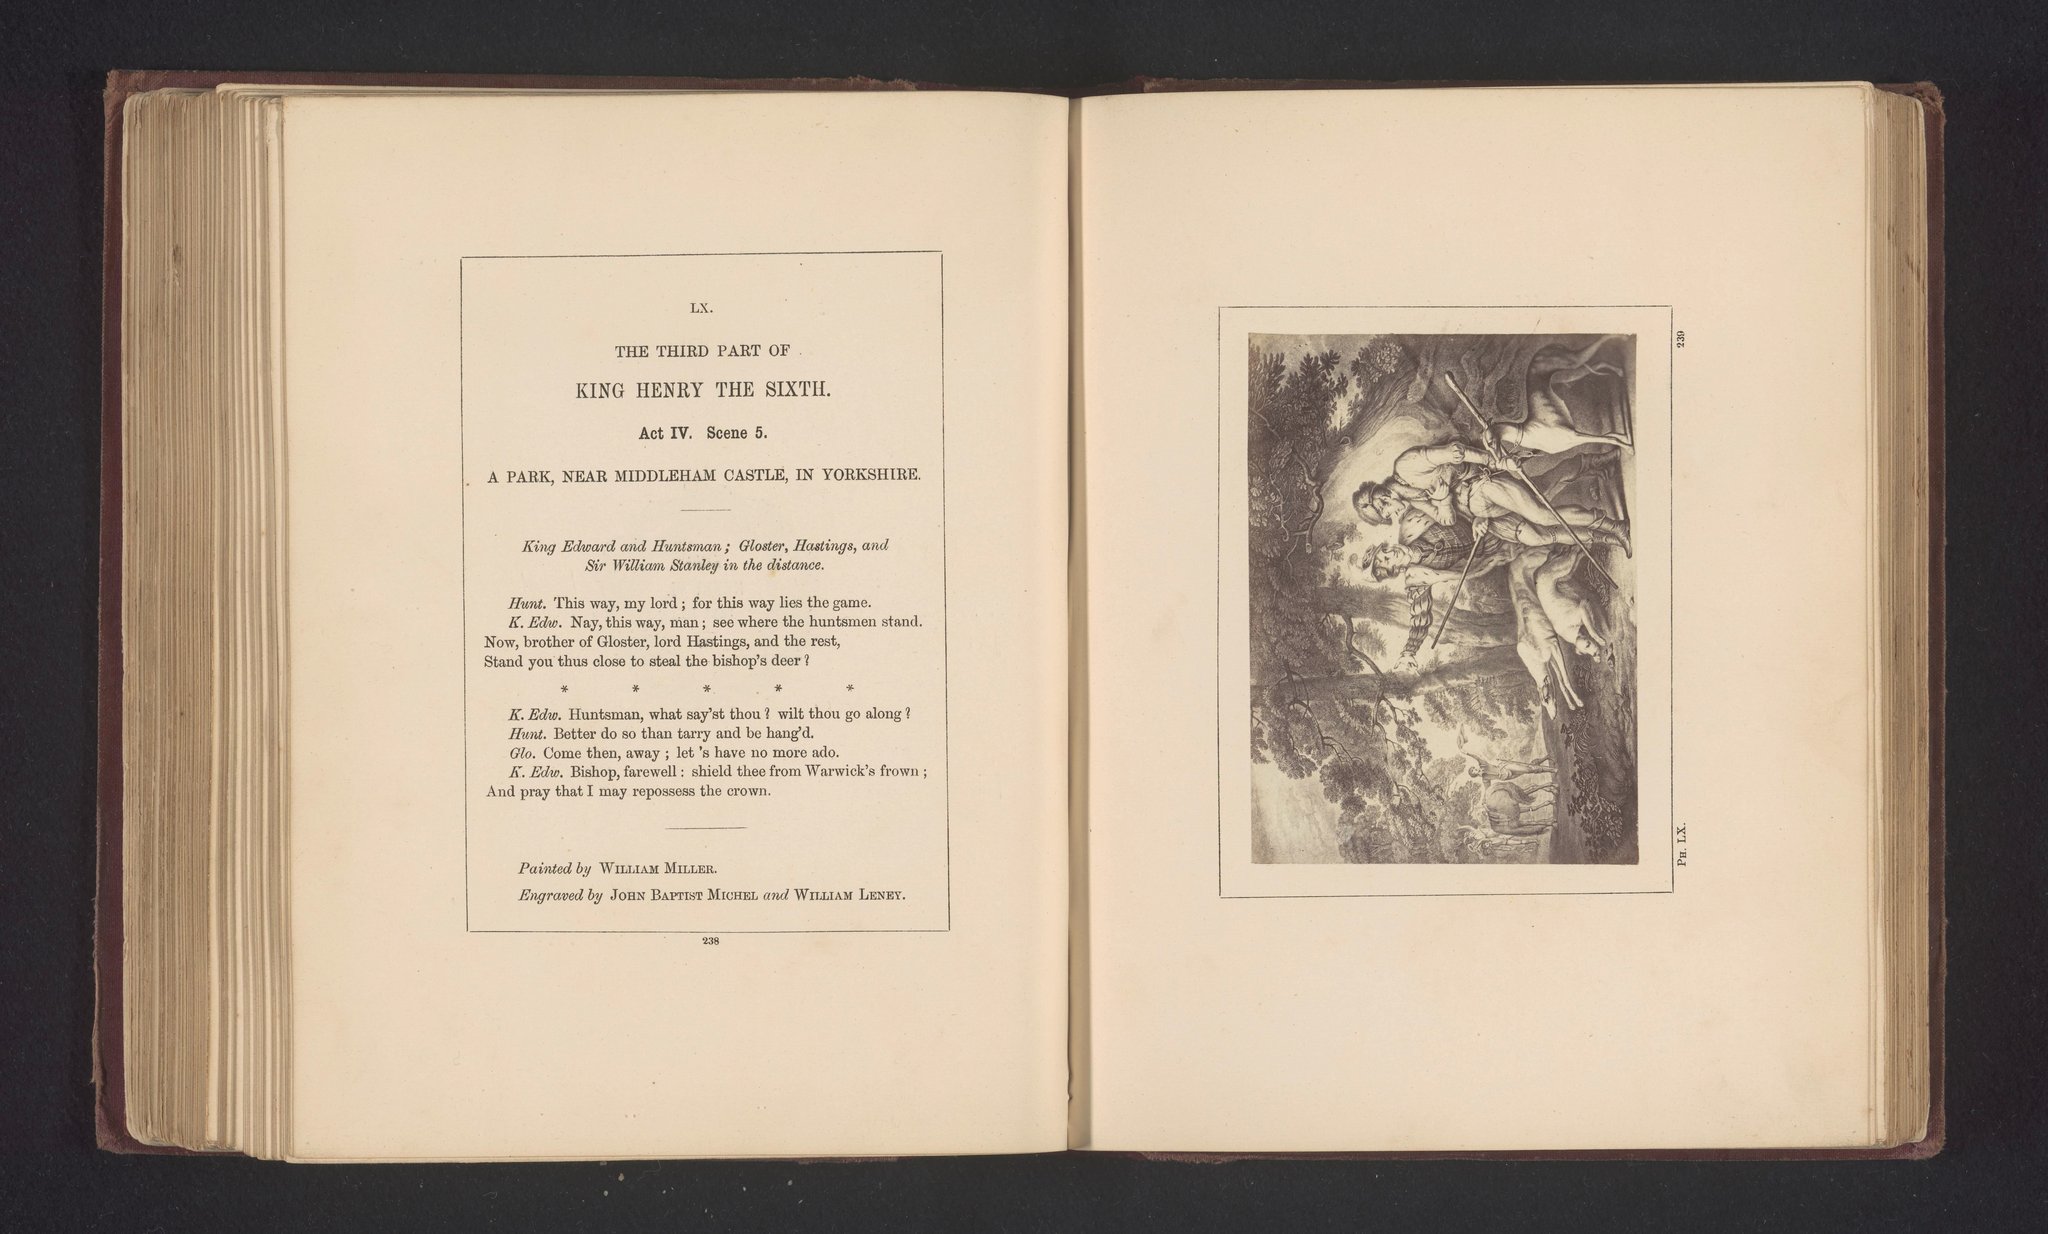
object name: page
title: Fotoreproductie van een prent naar een schilderij door William Miller, voorstellend een scene uit Hendrik VI, deel 3 door William Shakespeare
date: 1854-1867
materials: photographic support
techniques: albumen print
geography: london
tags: specific works of literature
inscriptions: number: ‘Ph. LX. 239’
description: Te zien is akte IV, scene 5 met koning Edward en een jager in een park.